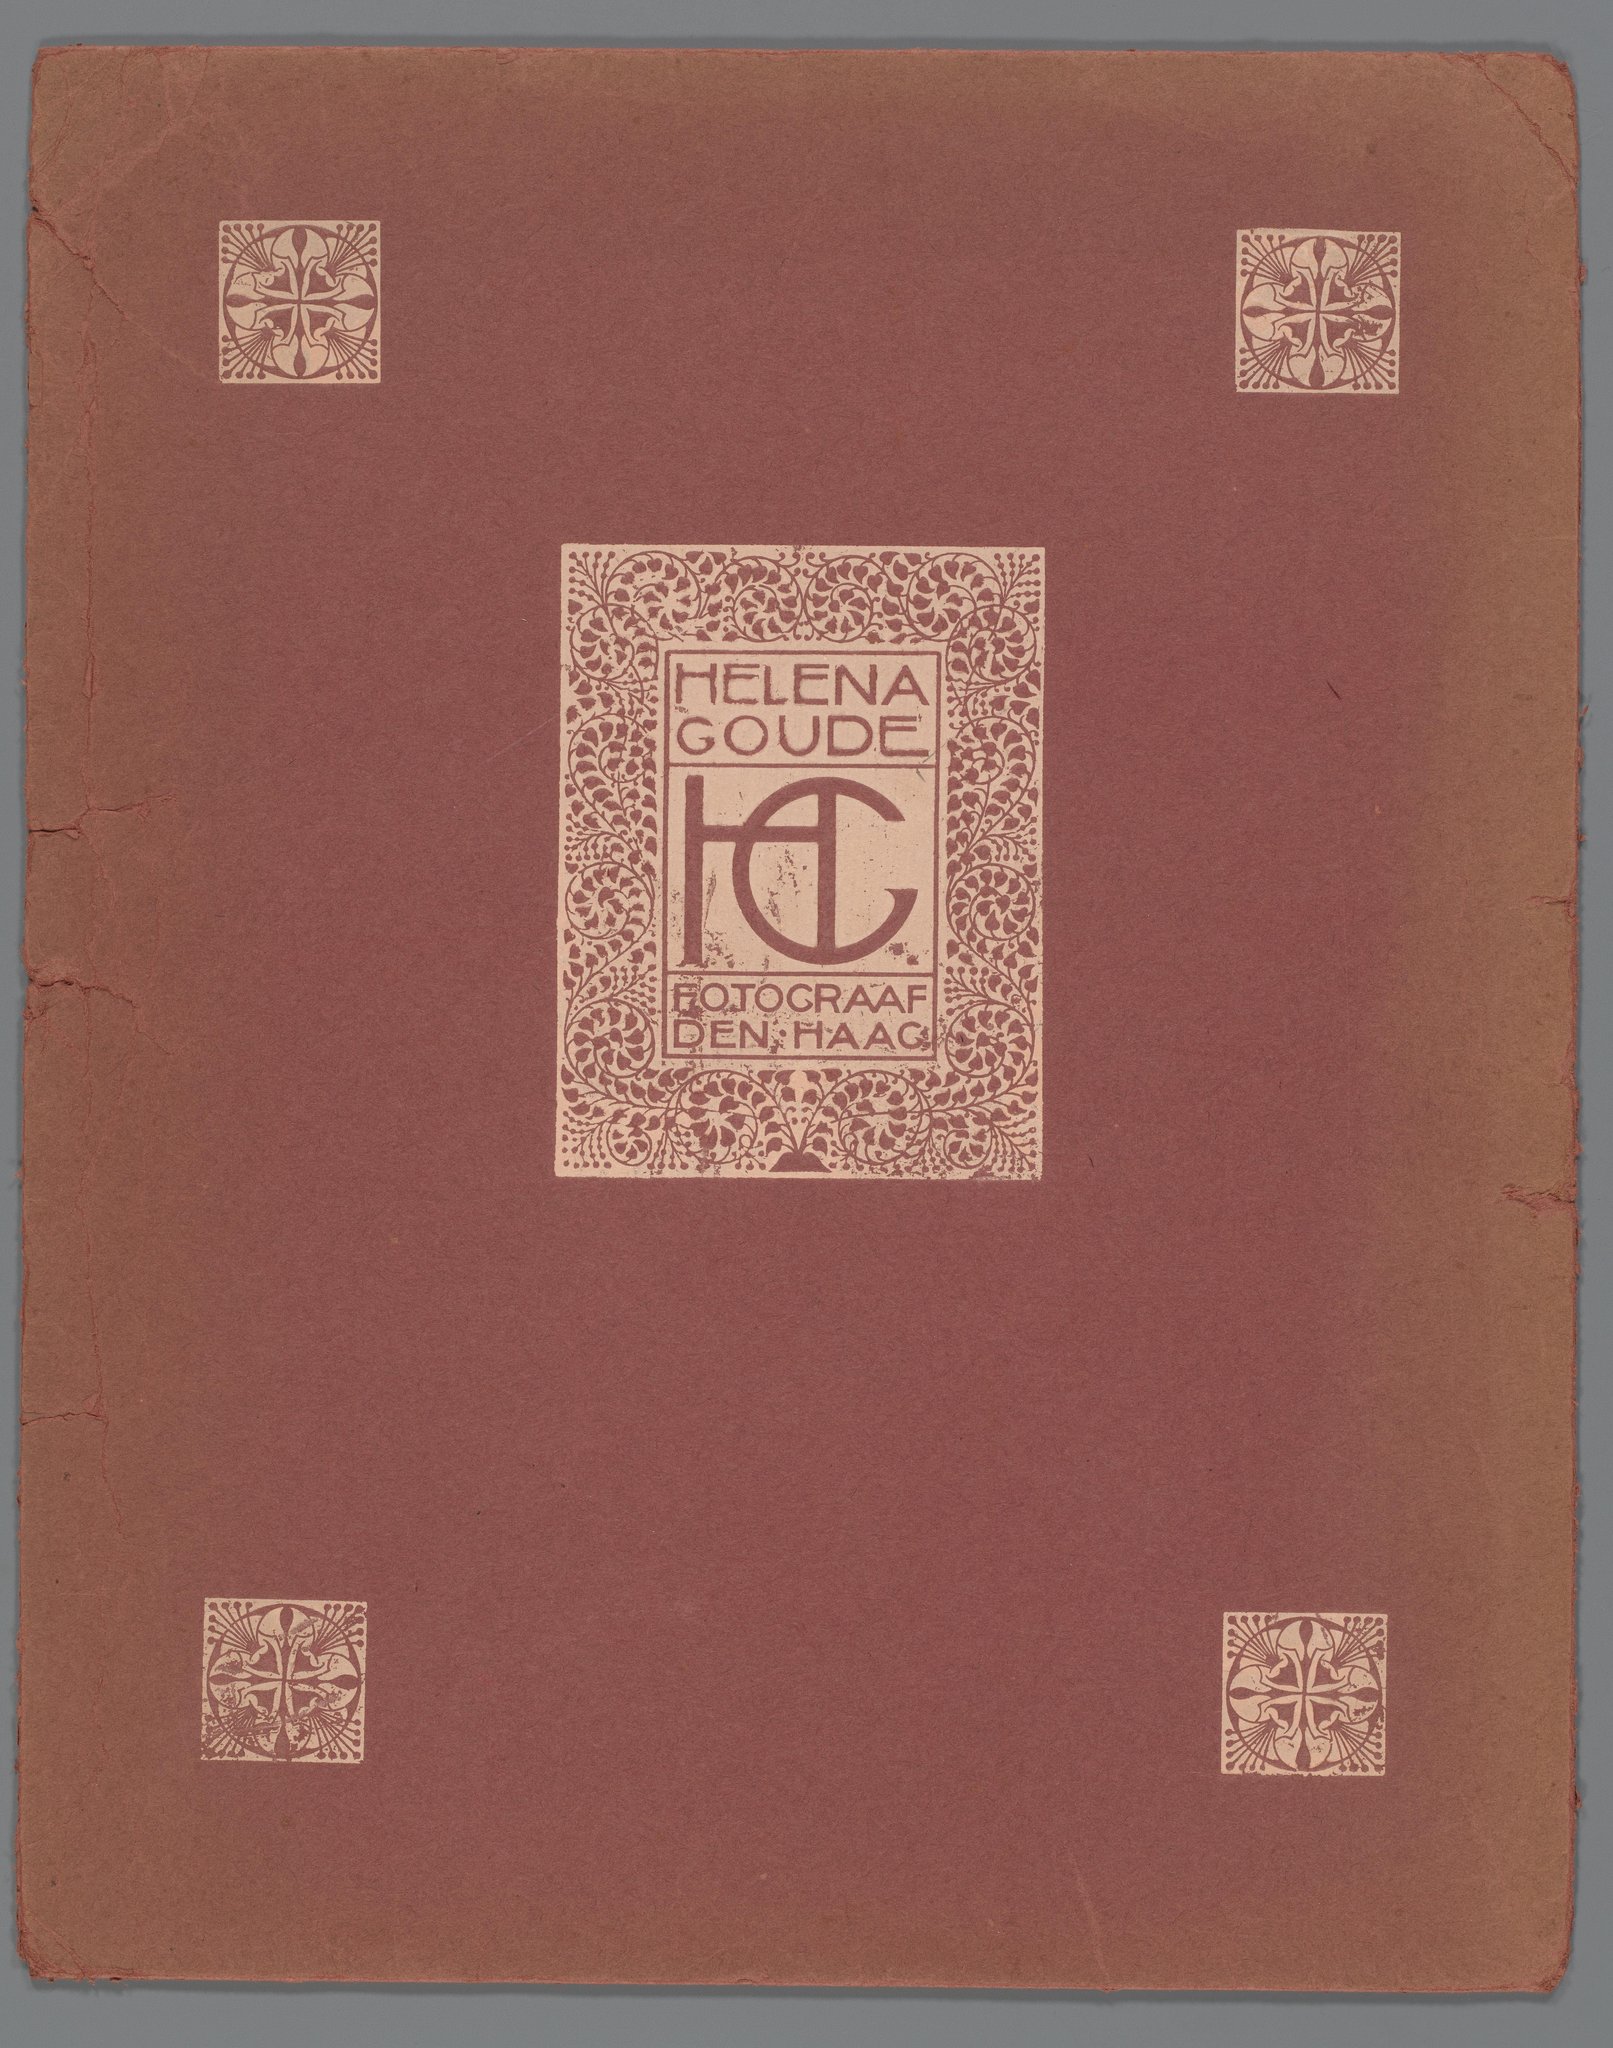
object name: wrapper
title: Map van Helena Goude, fotografe te Den Haag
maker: Anonymous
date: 1900-1943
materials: paper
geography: netherlands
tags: amsterdam, helena aleida goude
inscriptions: inscription: ‘HELENA/ GOUDE/ HG/ FOTOGRAAF/ DEN HAAG’